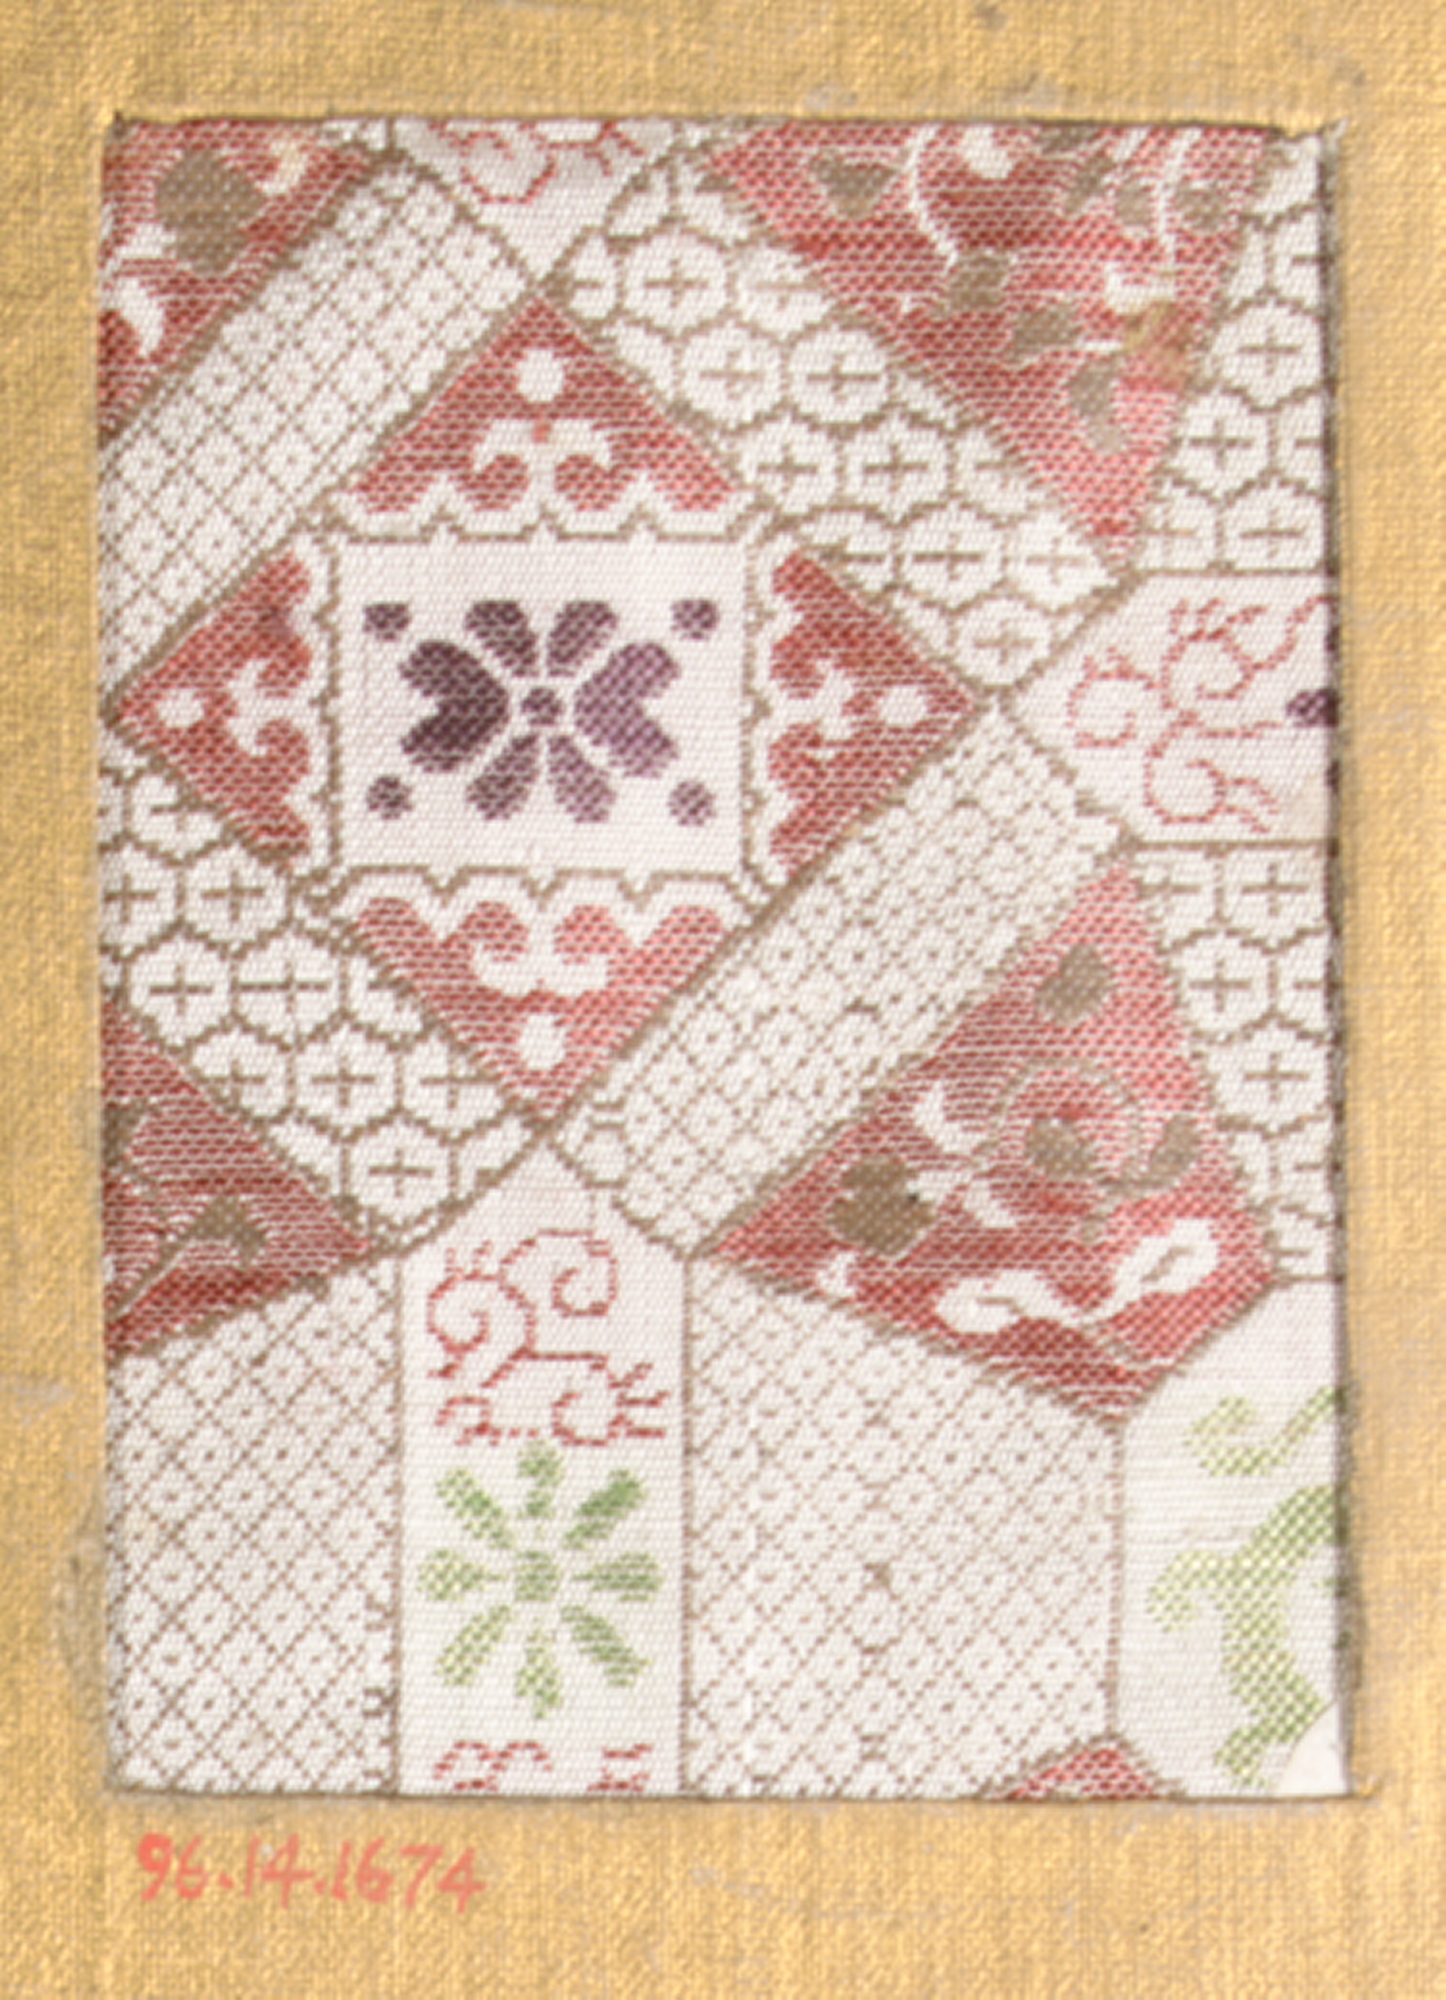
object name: piece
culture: japanese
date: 1701-1900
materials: silk